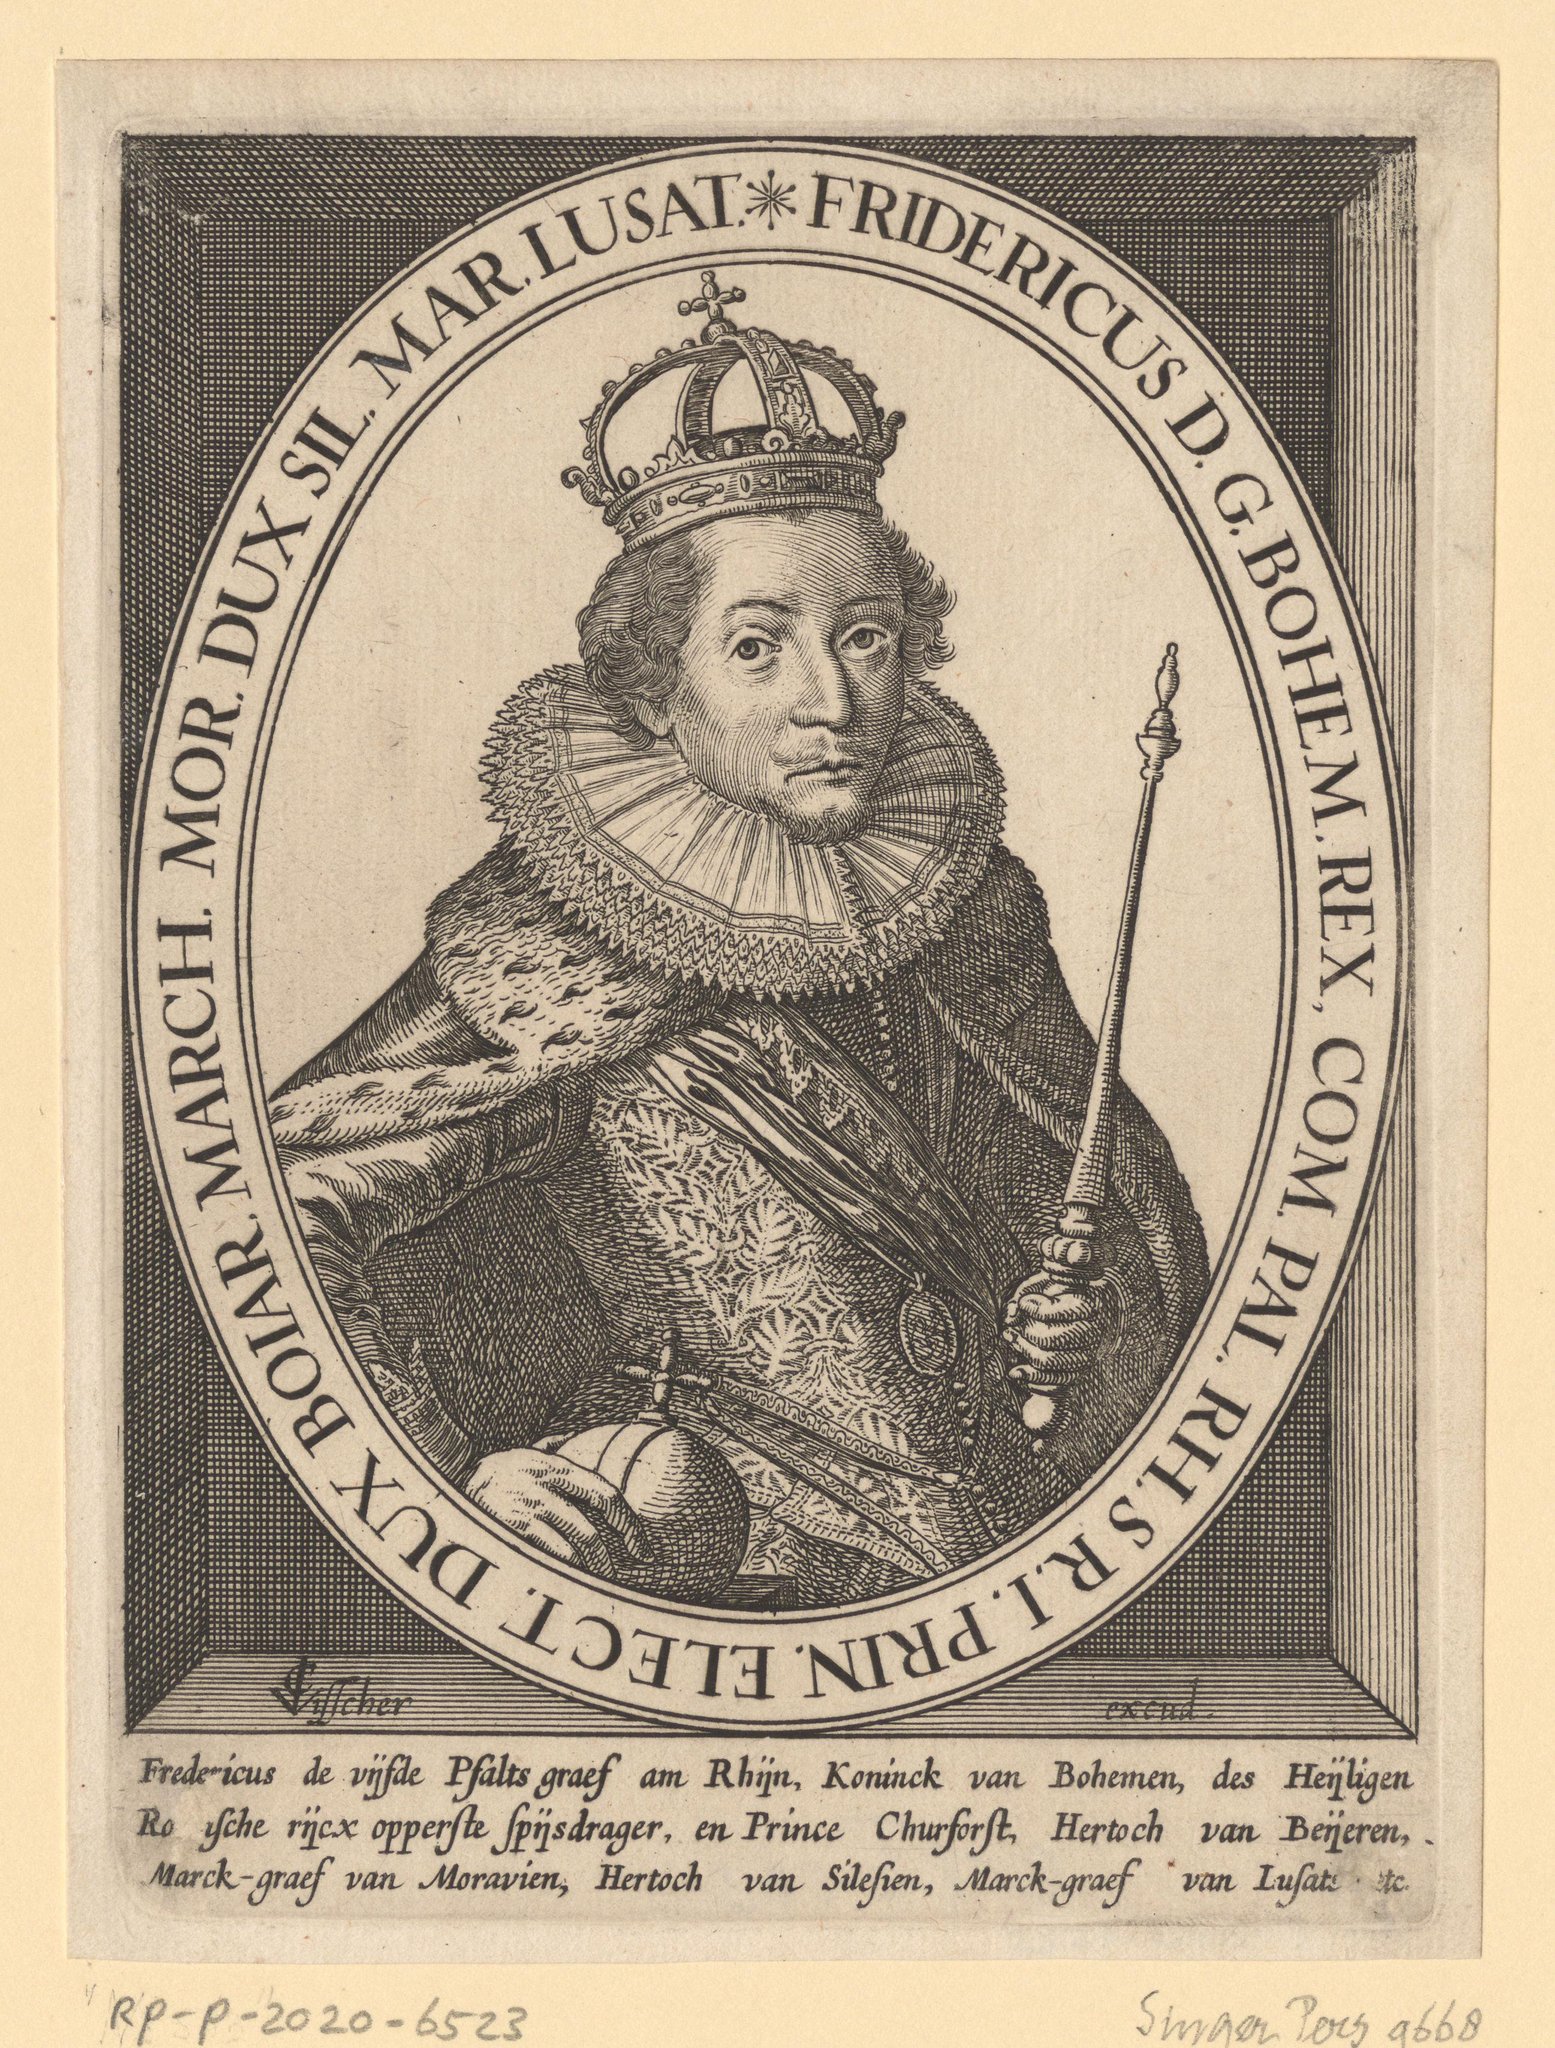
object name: print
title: Portret van Frederik V van de Palts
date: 1619-1652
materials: paper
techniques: engraving, etching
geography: northern netherlands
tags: frederik v (keurvorst van de palts, koning van bohemen), crown (symbol of sovereignty), orb (symbol of sovereignty; sphere with cross on top), sceptre, staff (symbol of sovereignty), historical persons, king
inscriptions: number: ‘No 563’